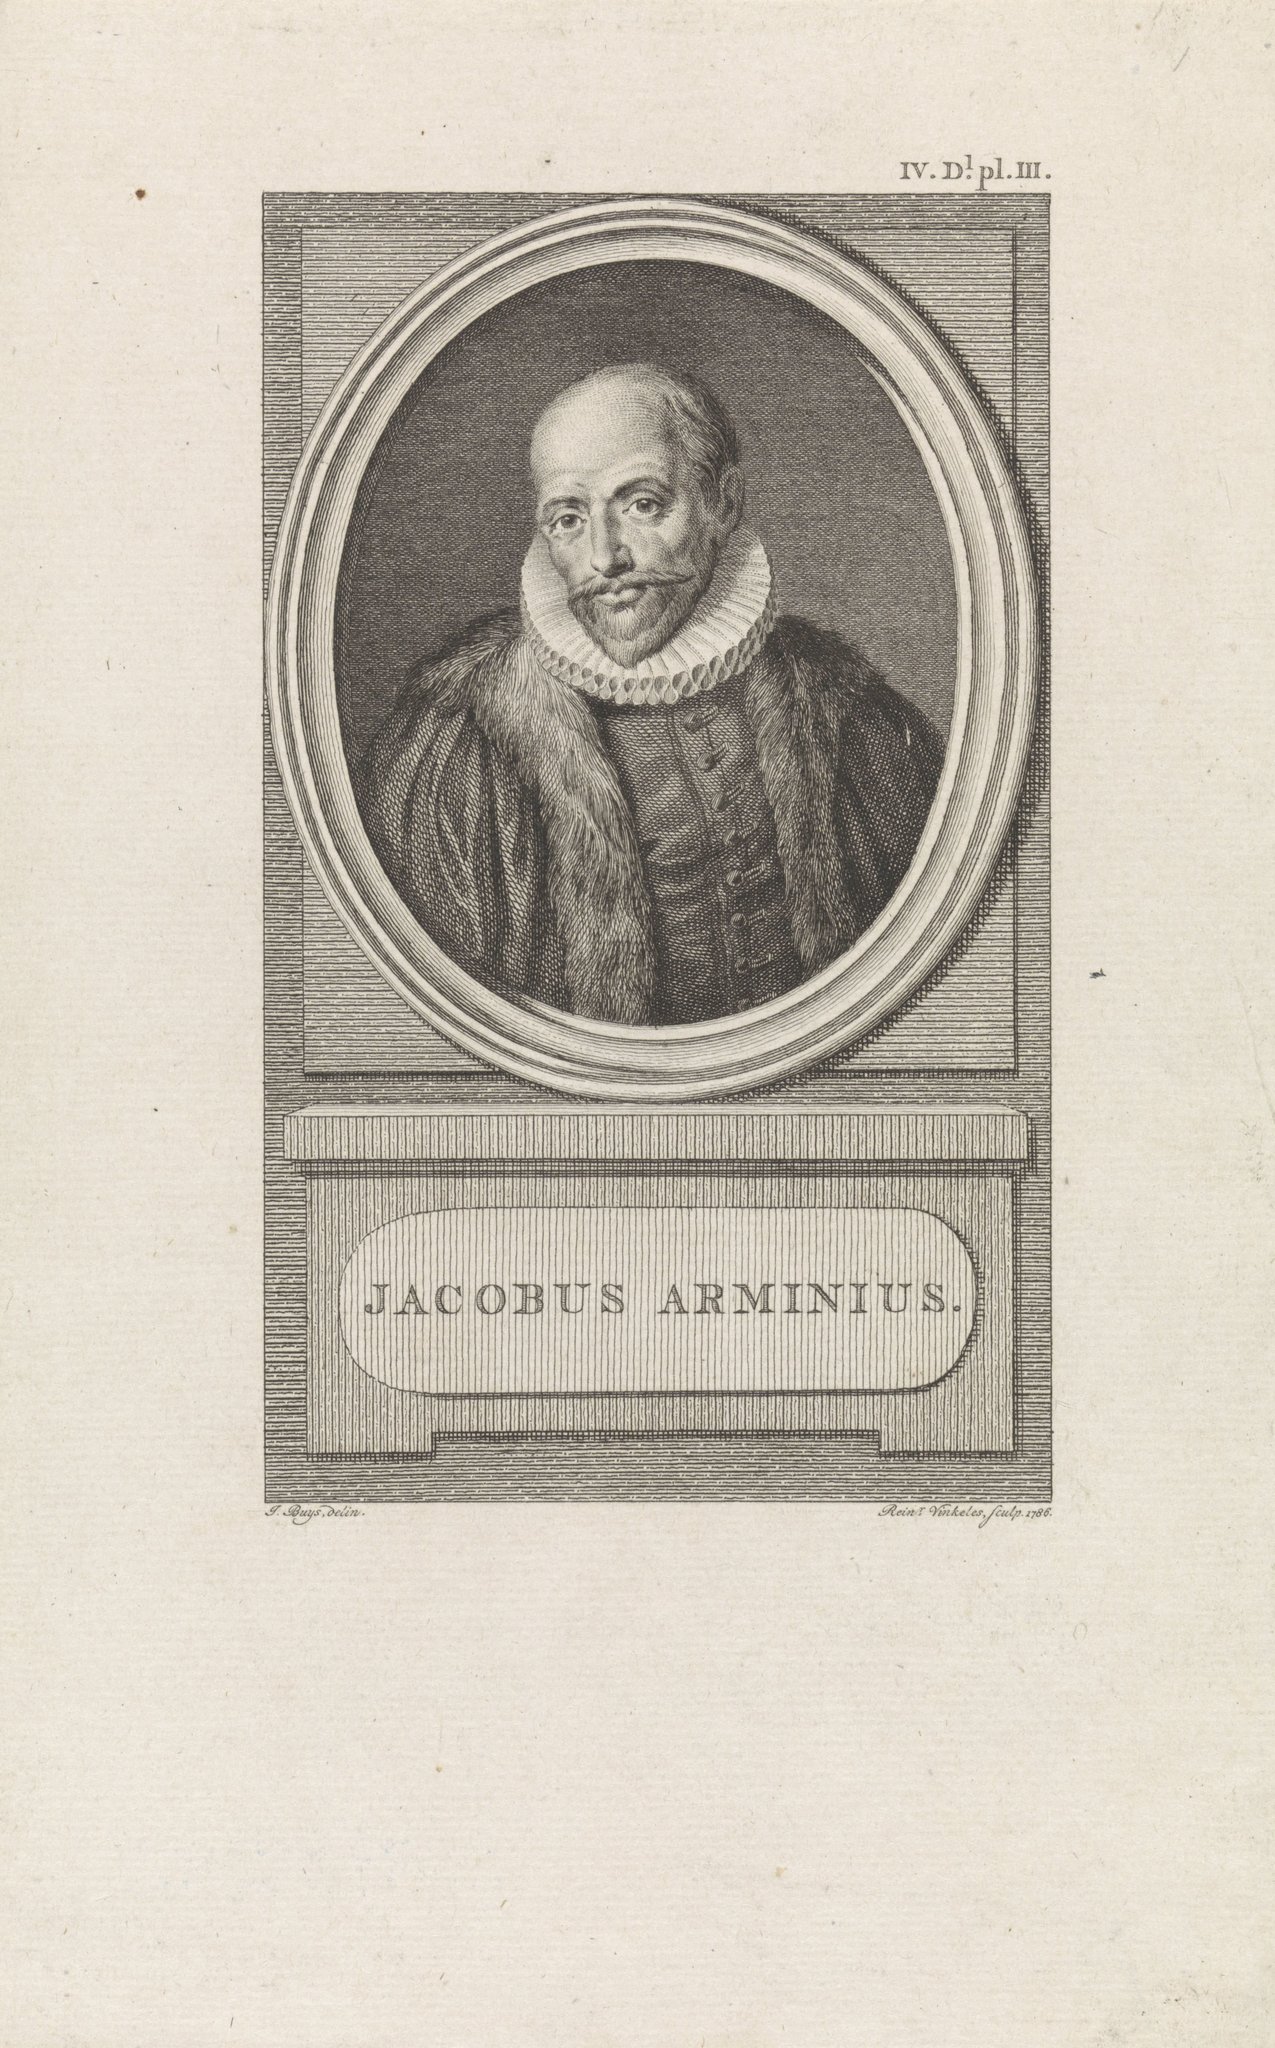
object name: book illustration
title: Portret van Jacobus Arminius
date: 1786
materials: paper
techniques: engraving, etching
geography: amsterdam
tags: oudewater, predikant, professor in de theologie, jacobus arminius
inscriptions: collector's mark: Lugt 2228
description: Prent gebruikt als boekillustratie in: Kok, Jacobus. Vaderlandsch woordenboek : met kaarten, plaaten en pourtraitten. Amsterdam: Johannes Allart, 1785-1796. Deel IV.